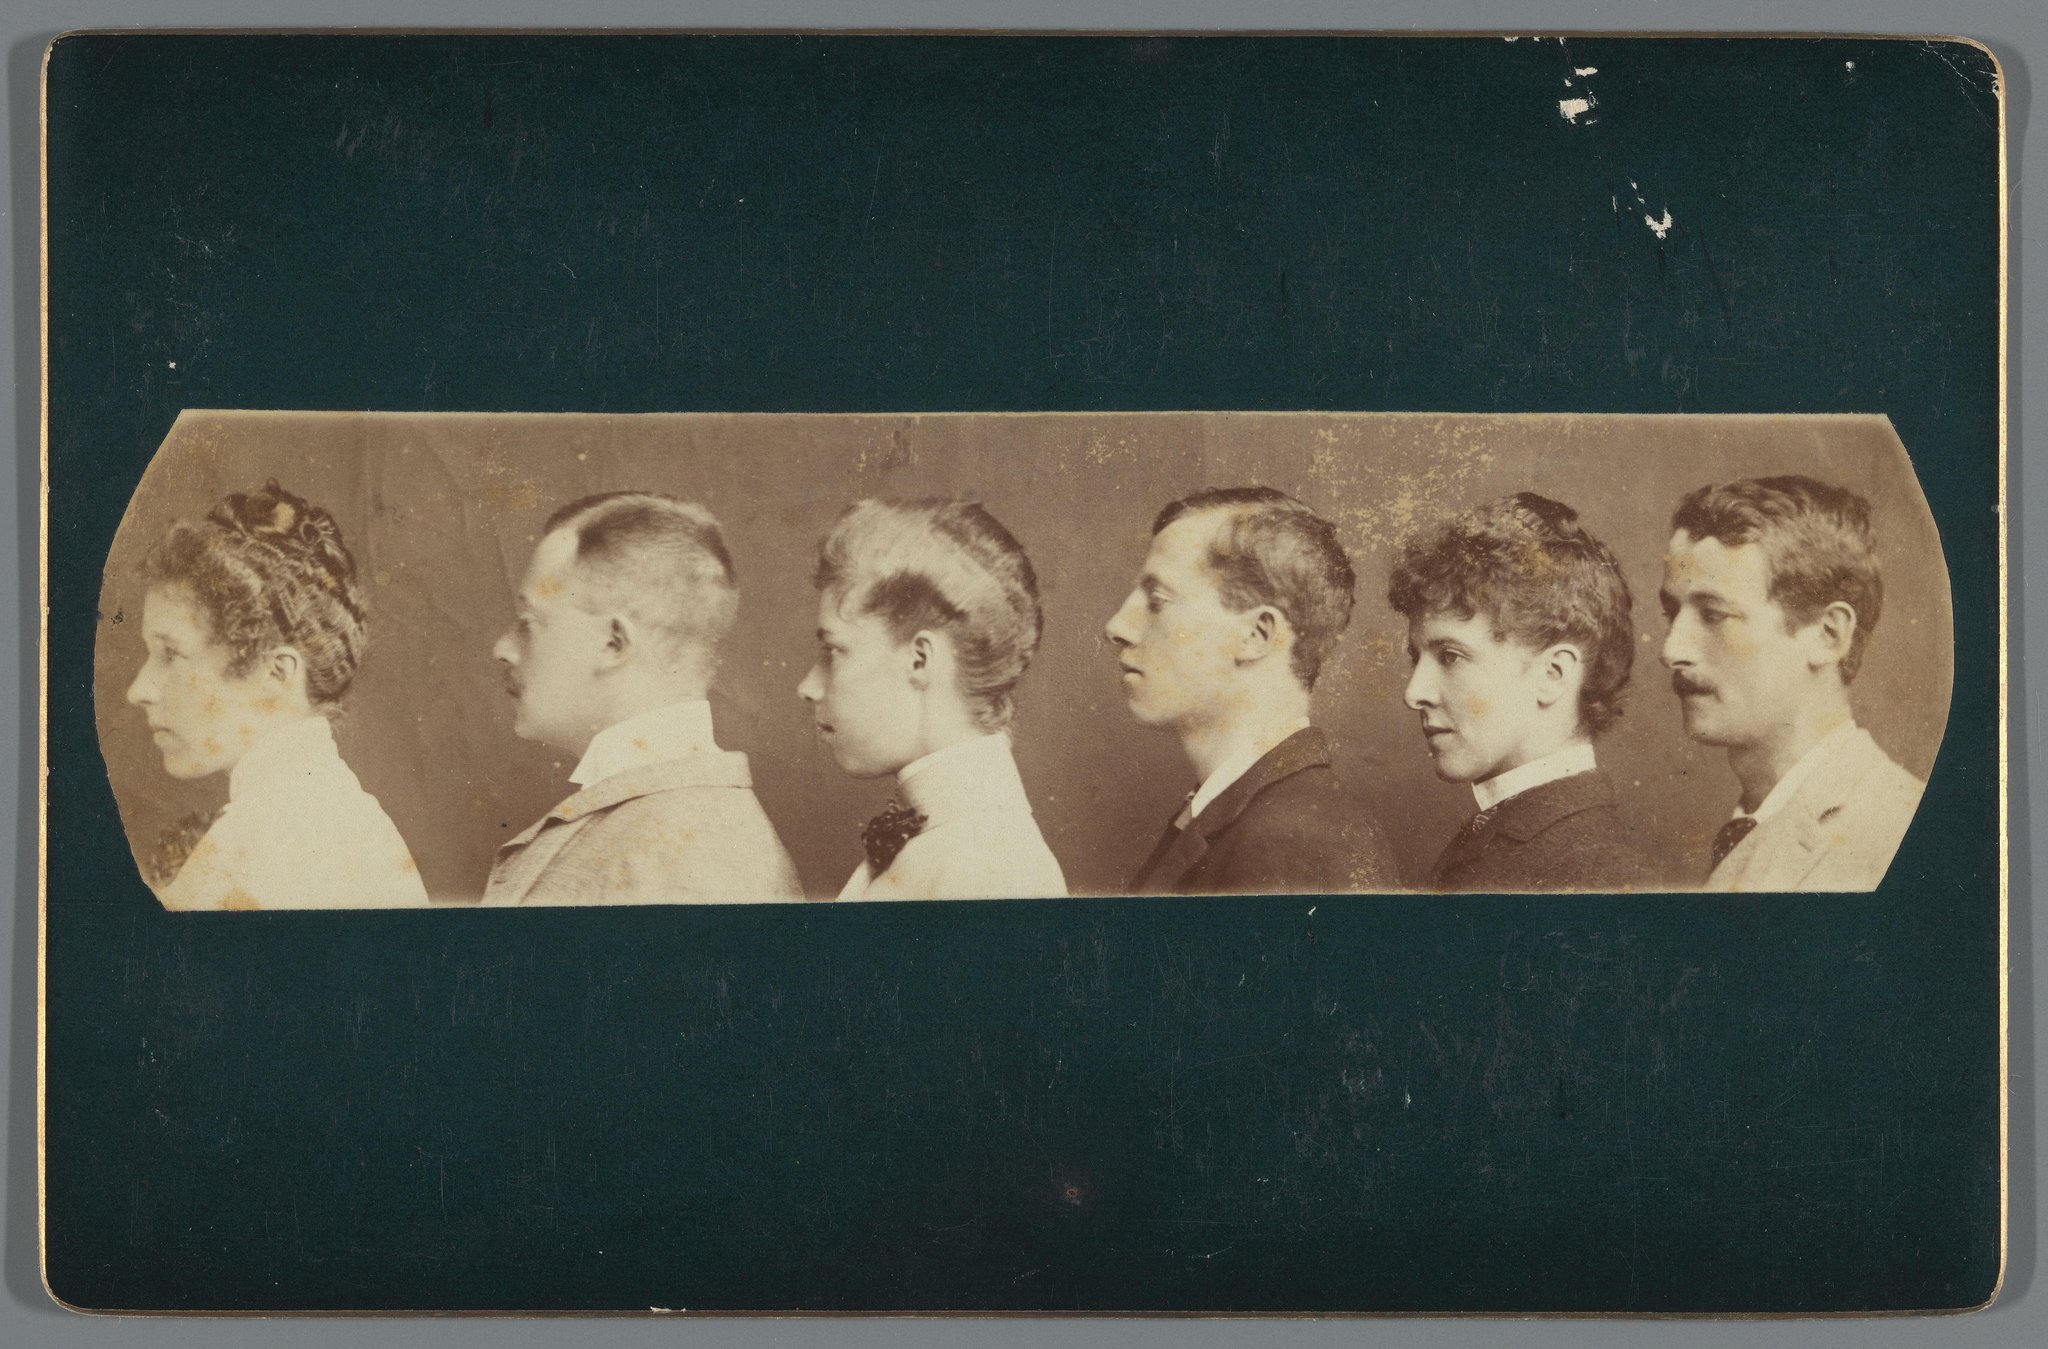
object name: photograph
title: Groepsportret van zes jonge mensen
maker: Anonymous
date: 1890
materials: cardboard, photographic support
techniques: collodion silver print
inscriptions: inscription: ‘Namen van de afgebeelde personen. [1890 Sentenced by the Right Hon. the Lord Justice clerk to various ... from 5 to 18 years. Prisoners right ...]’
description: Groepsportret van zes jonge mensen; 3 vrouwen en jonge mannen en profil.